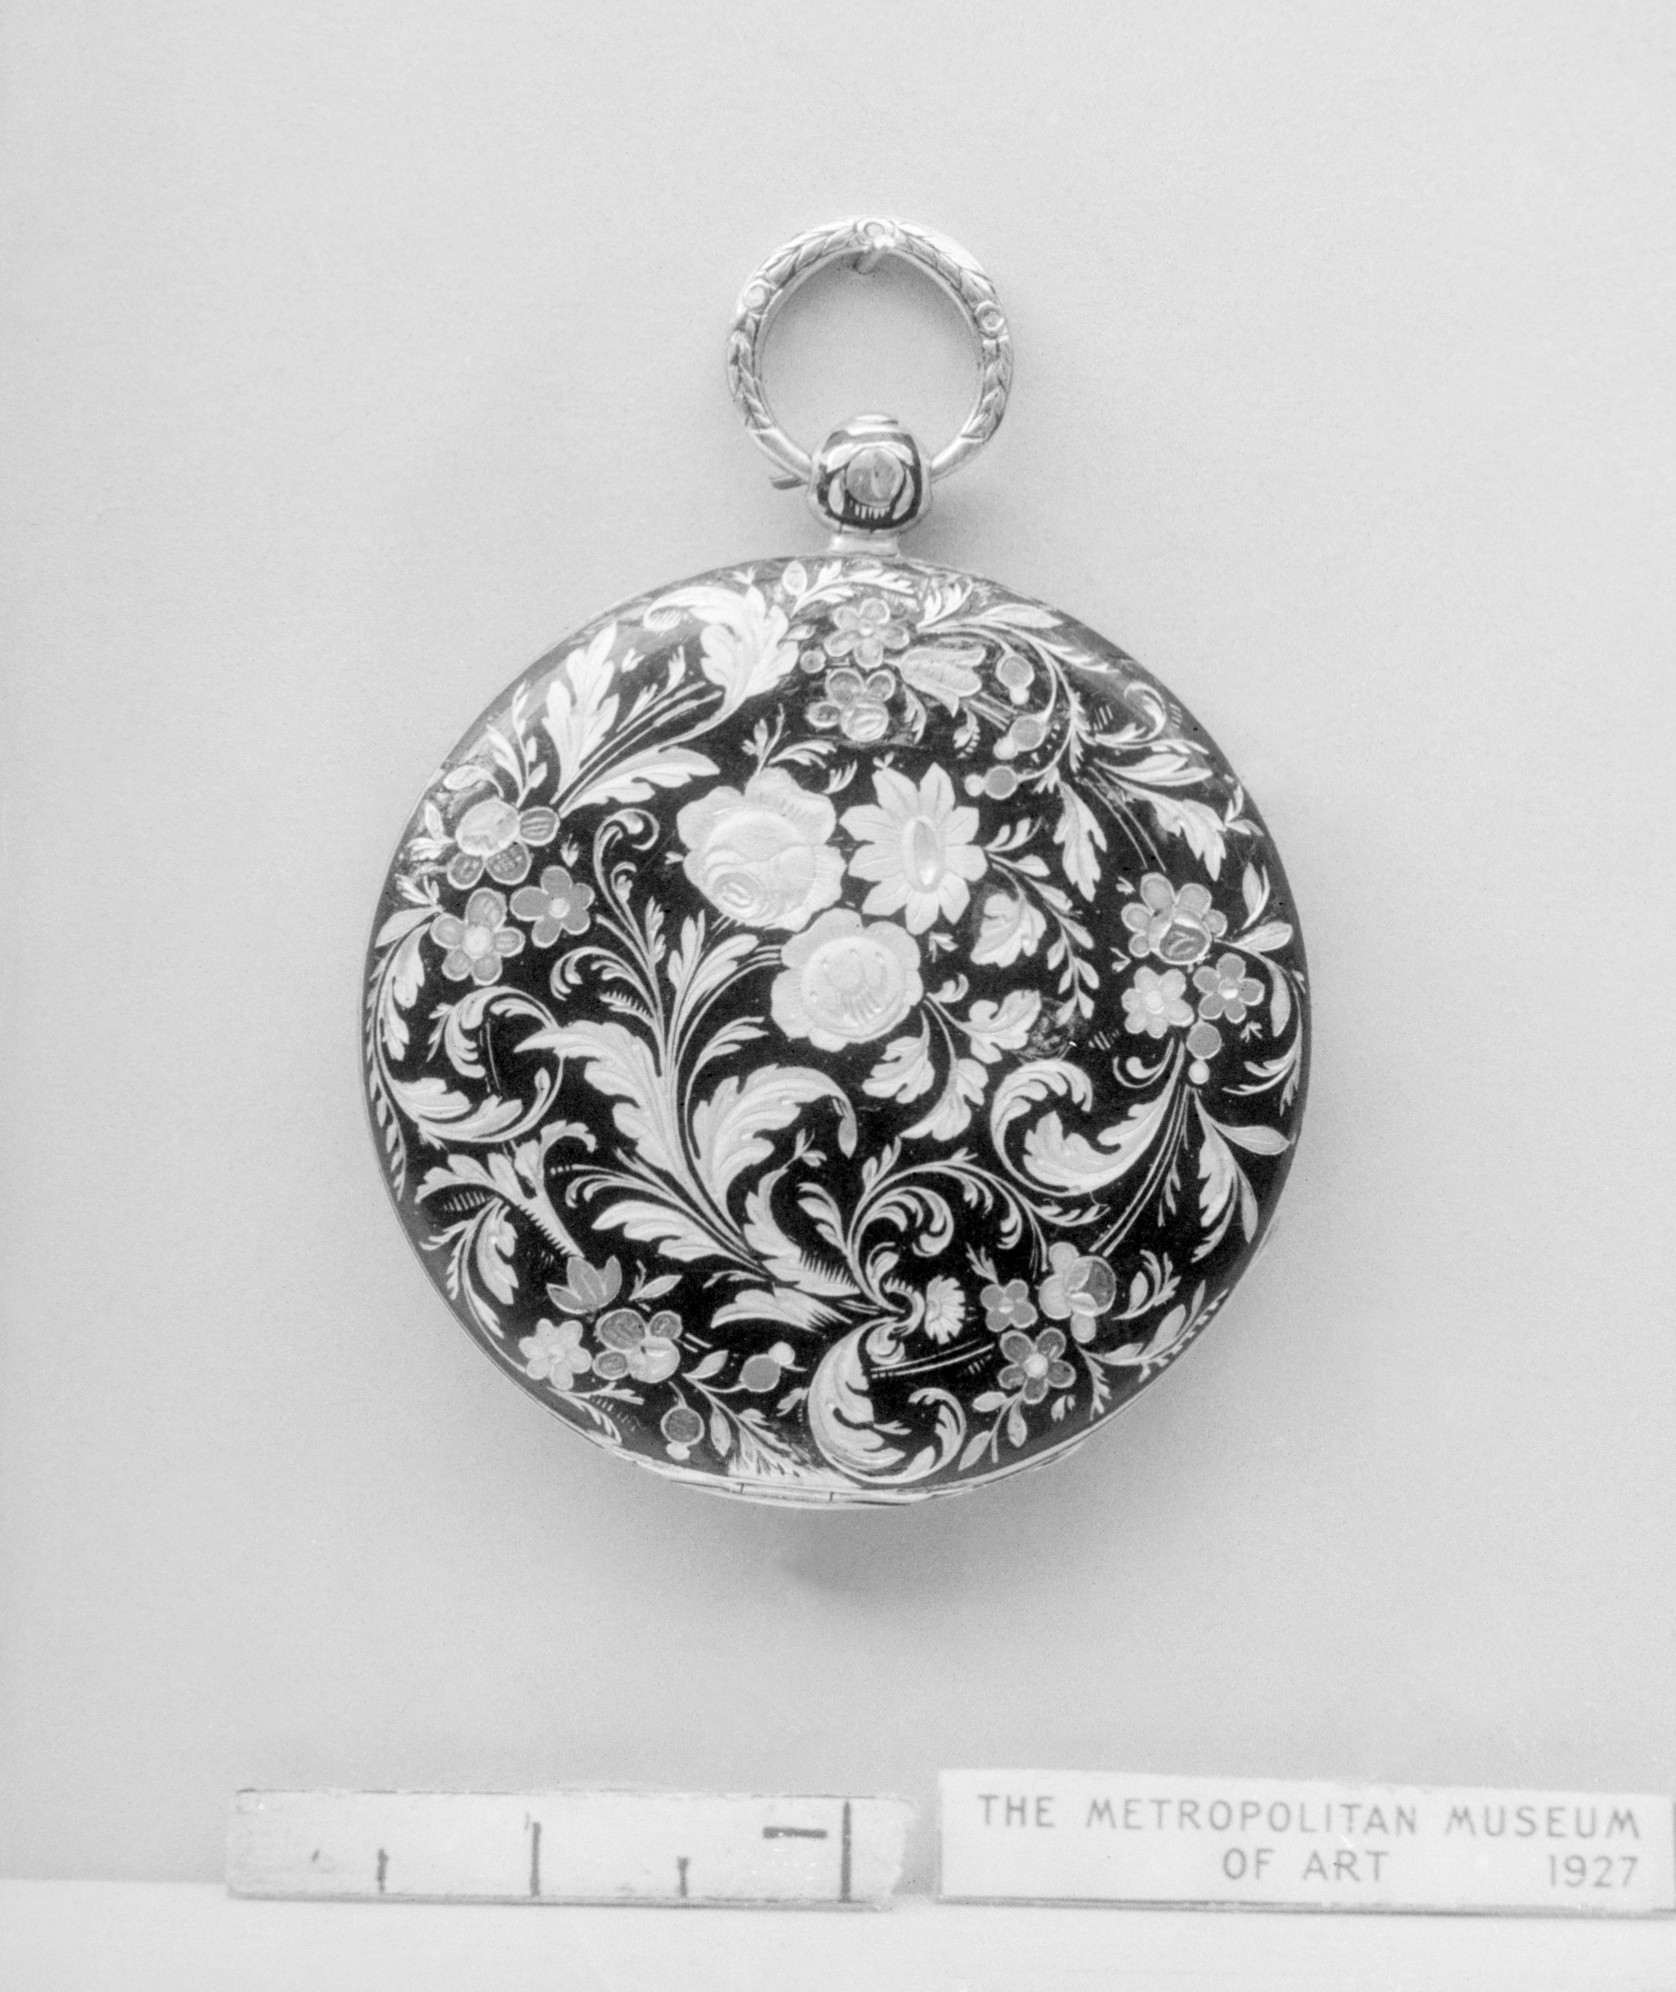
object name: watch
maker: s. devaulx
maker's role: maker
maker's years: 1822-1838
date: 1801-1900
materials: enamel, gold, silver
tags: flowers,roses,leaves